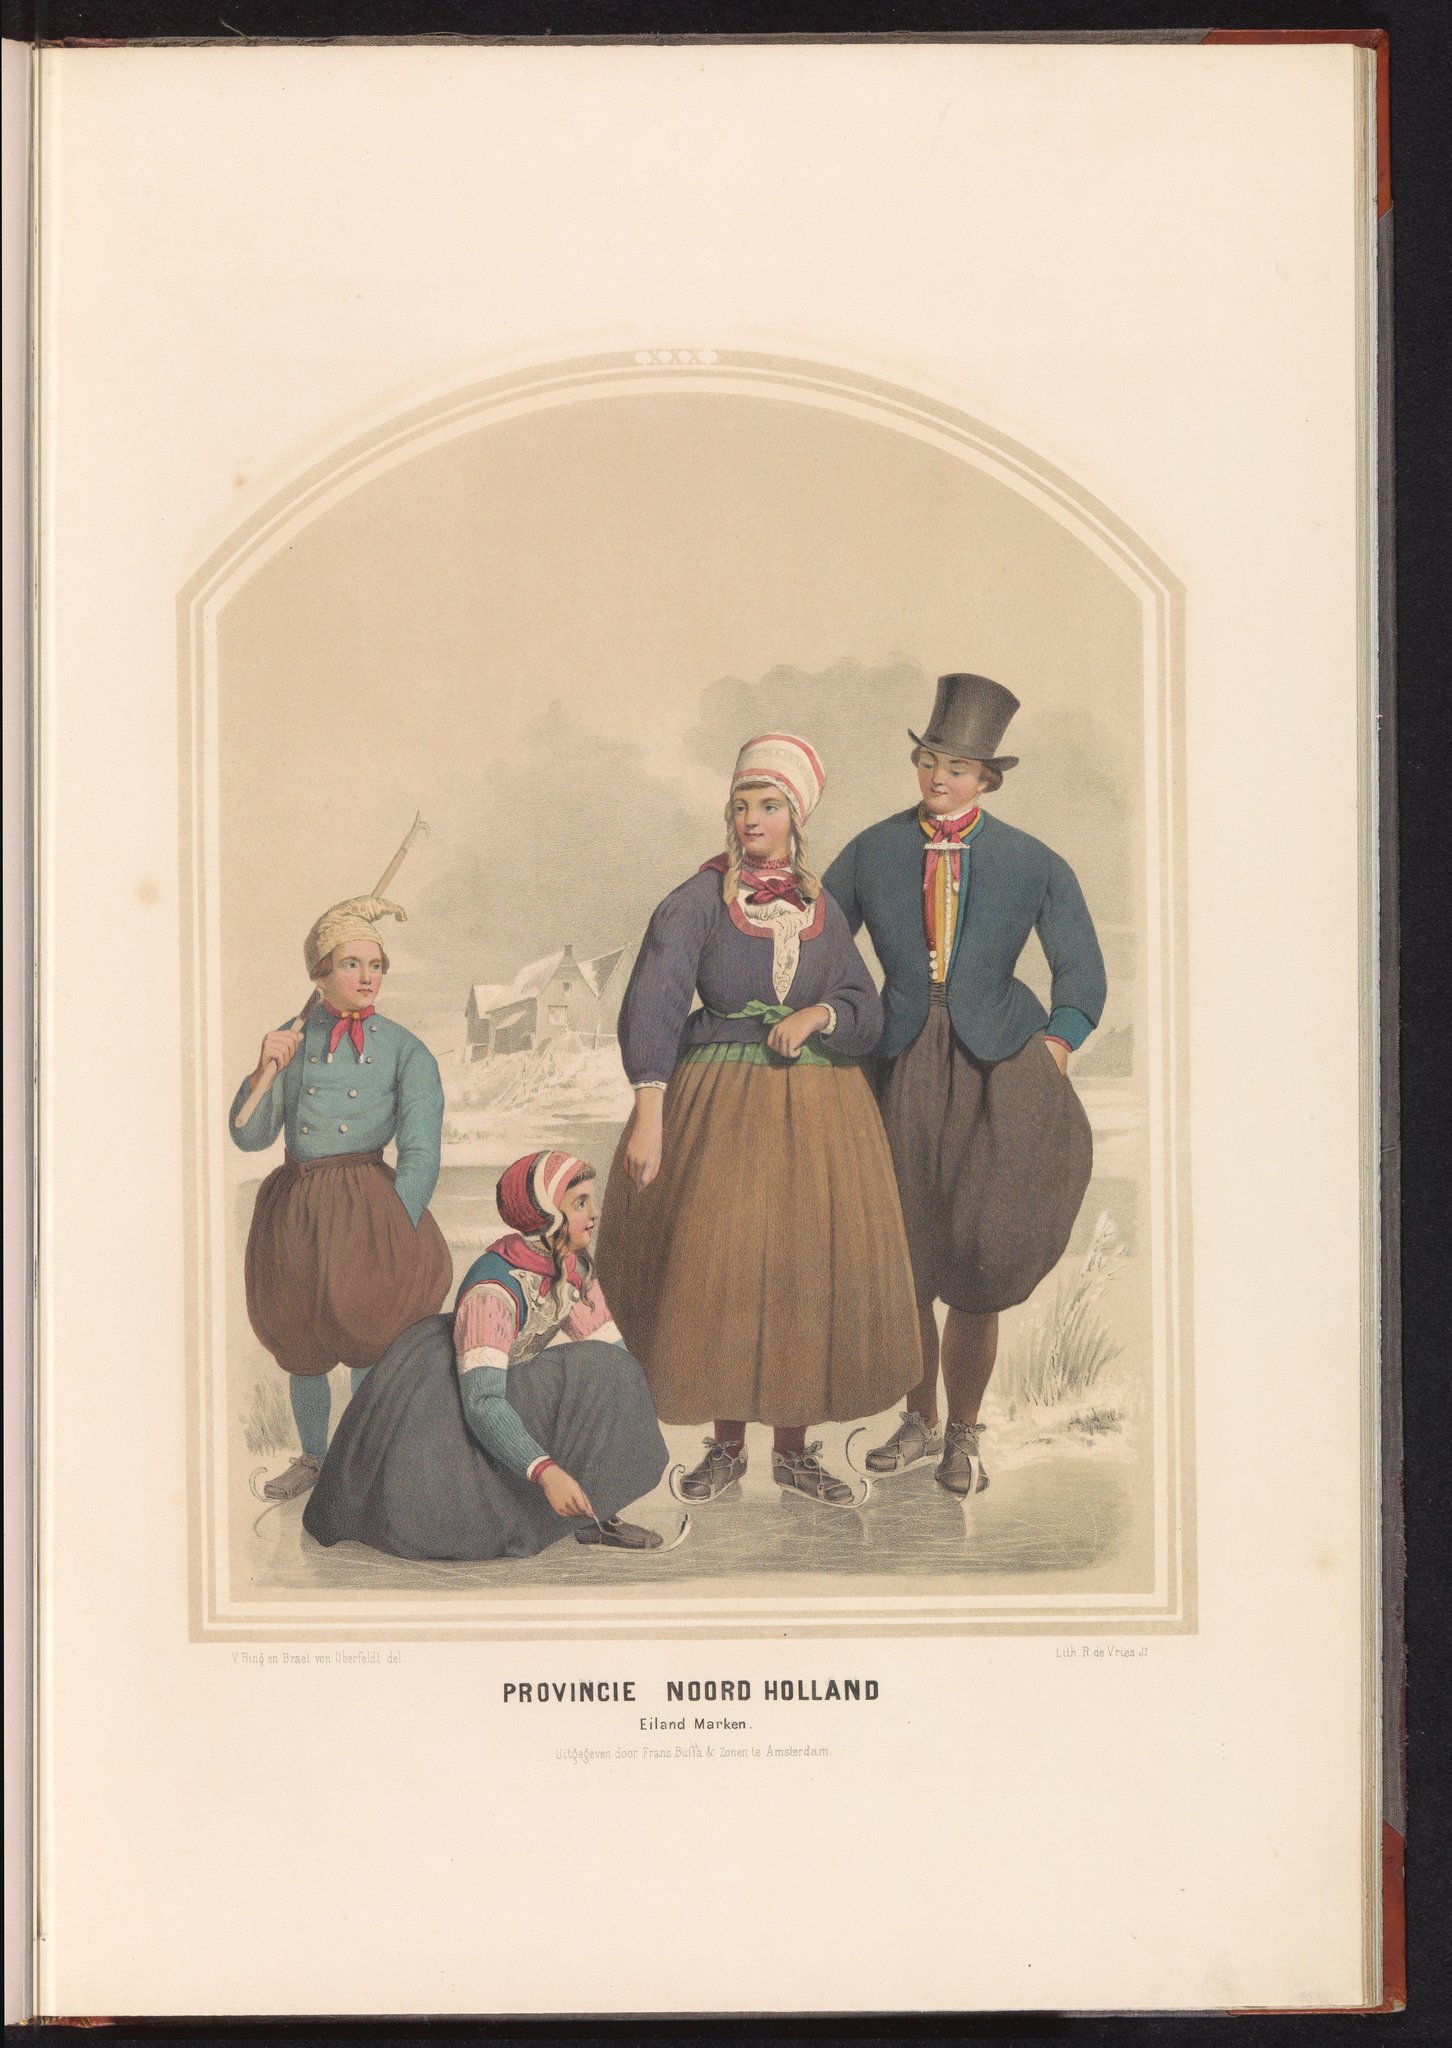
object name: print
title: Provincie Noord-Holland. Eiland Marken / XXX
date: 1857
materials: paper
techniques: hand coloring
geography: amsterdam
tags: skates (winter sports), folk costume, regional costume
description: Klederdracht van het eiland Marken in Noord-Holland. Familie op schaatsen op het ijs. Illustratie in een boek uit 1857 met 56 platen van Nederlandse klederdrachten.